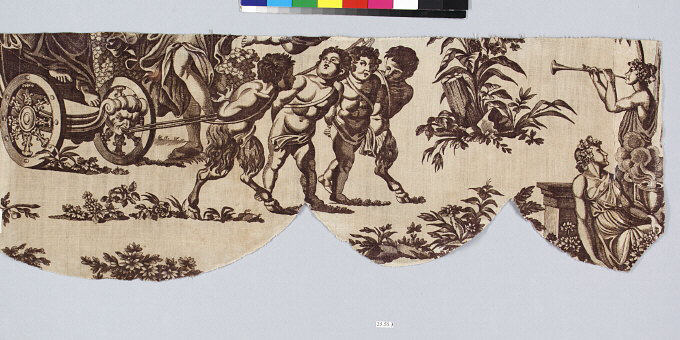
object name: piece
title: Europa and the Bull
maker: petitpierre et cie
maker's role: manufactory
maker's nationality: french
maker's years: 1790-1802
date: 1800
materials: cotton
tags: musical instruments,europa,carriages